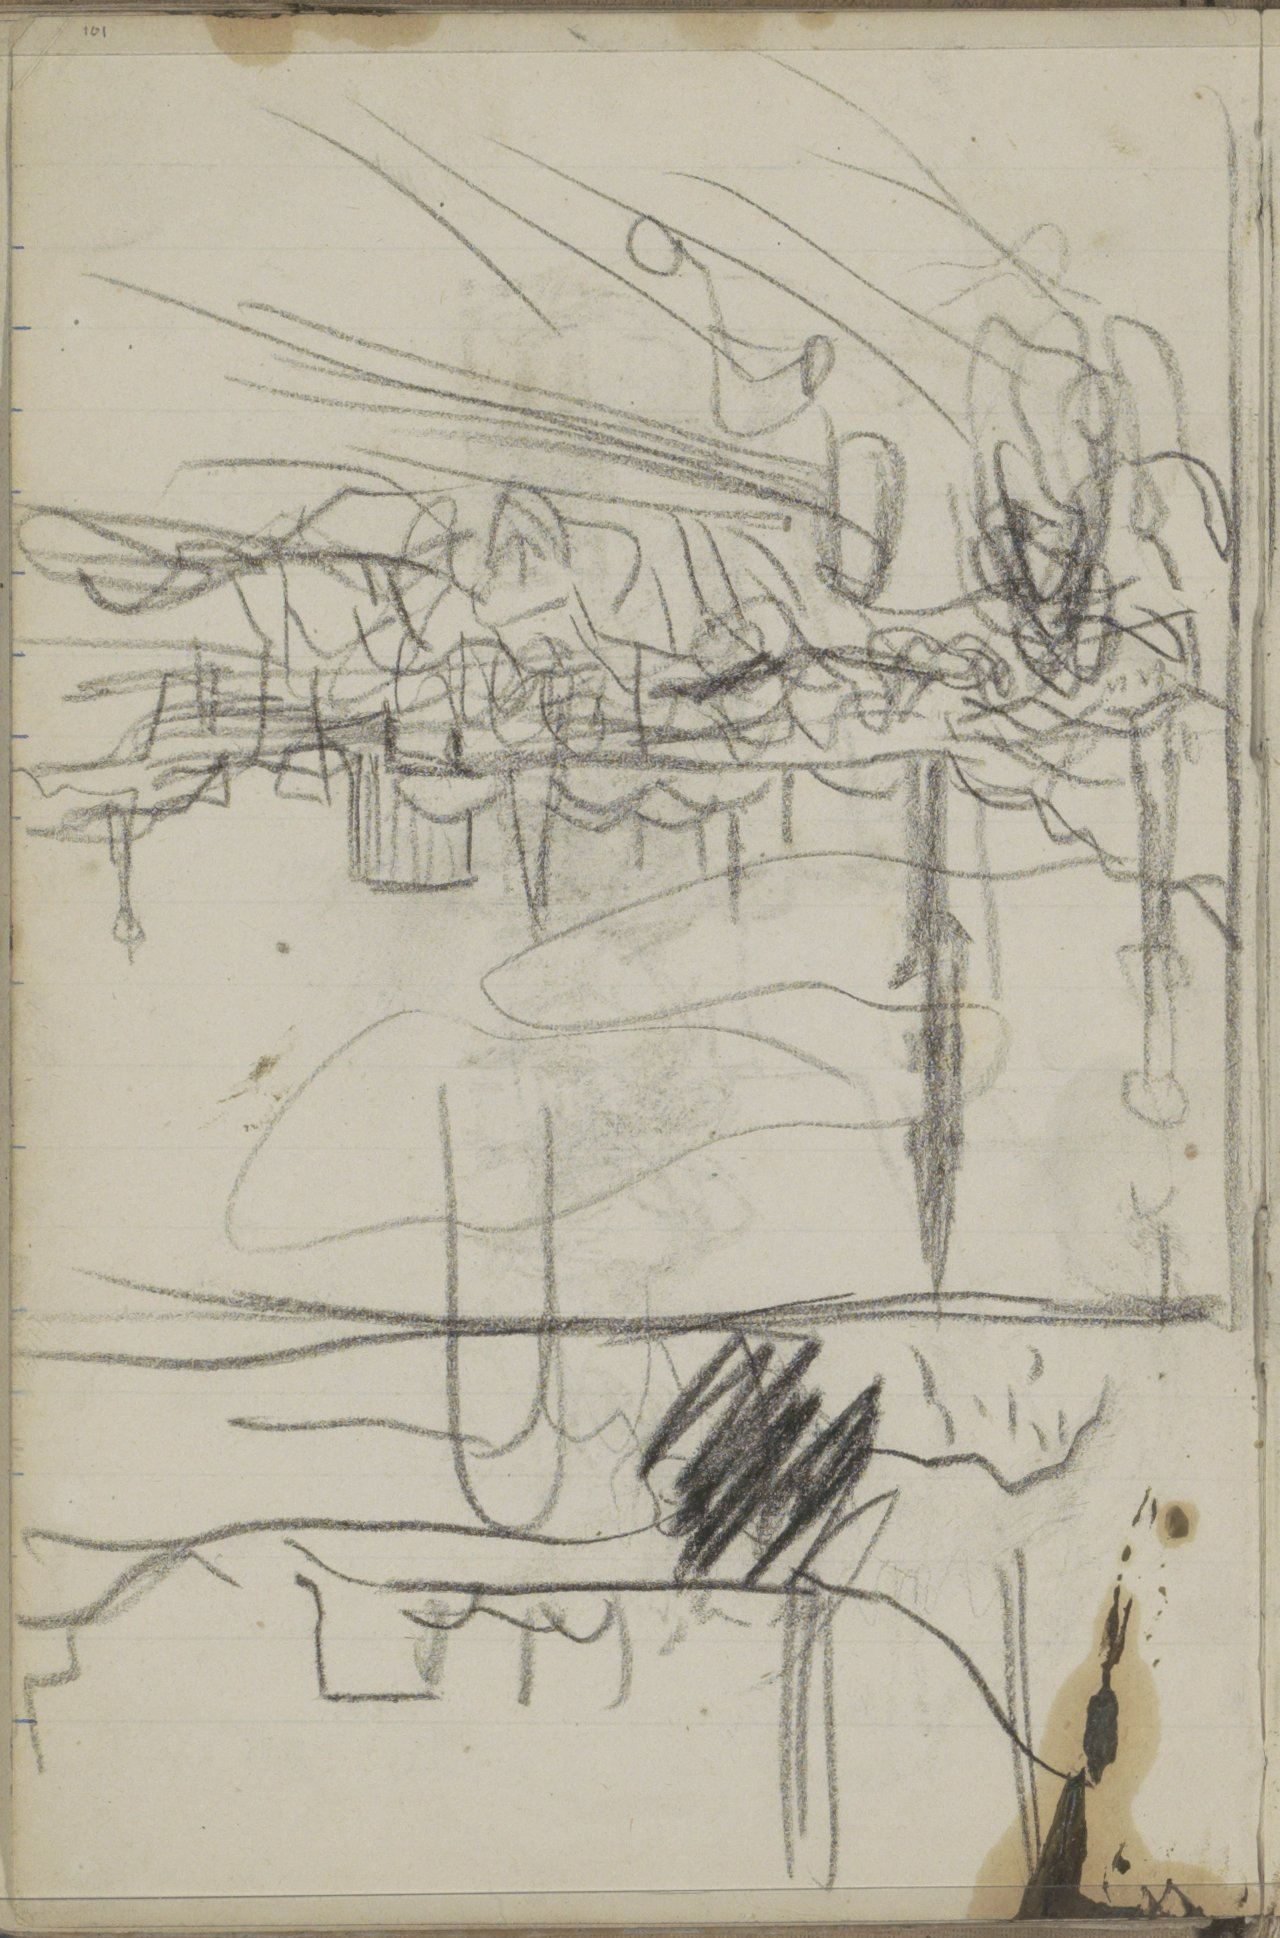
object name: sketchbook leaf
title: Gezicht op Constantinopel vanaf een weg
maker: marius bauer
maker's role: draughtsman, print maker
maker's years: 1867-1932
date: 1888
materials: chalk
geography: istanbul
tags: road, path, temple, shrine ~ islam, mohammedanism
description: Op de achtergrond de minaretten en koepels van verschillende moskeeën. Pagina 101 uit een schetsboek met 58 bladen.